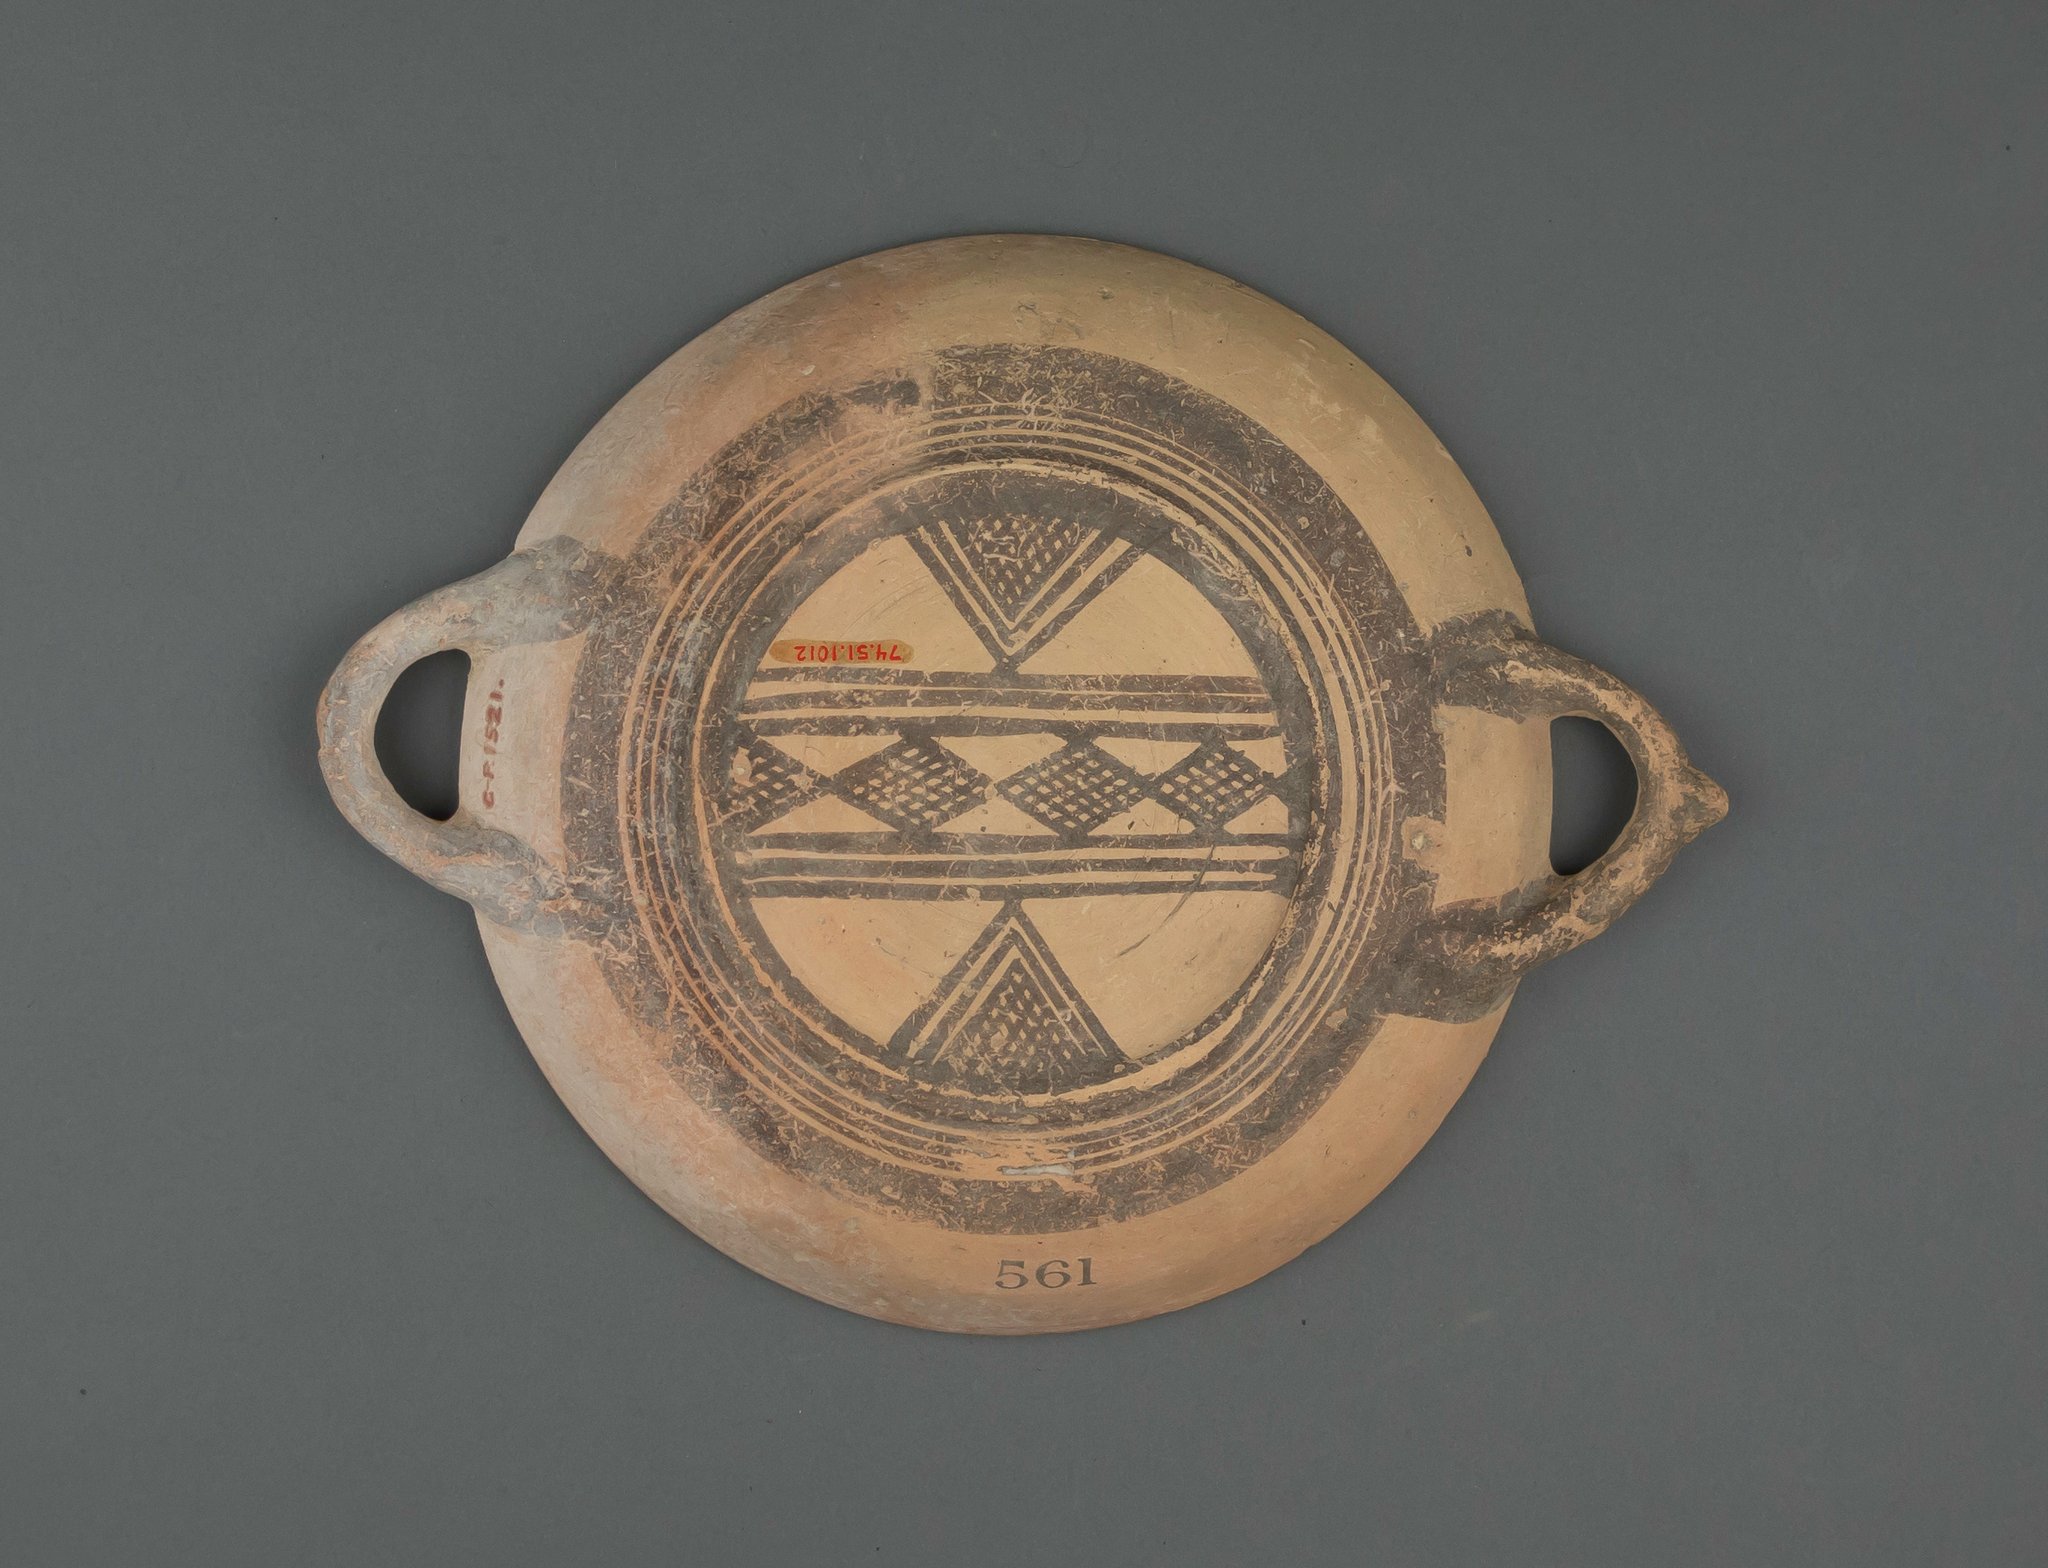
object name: plate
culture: cypriot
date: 1050-900 BCE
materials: terracotta